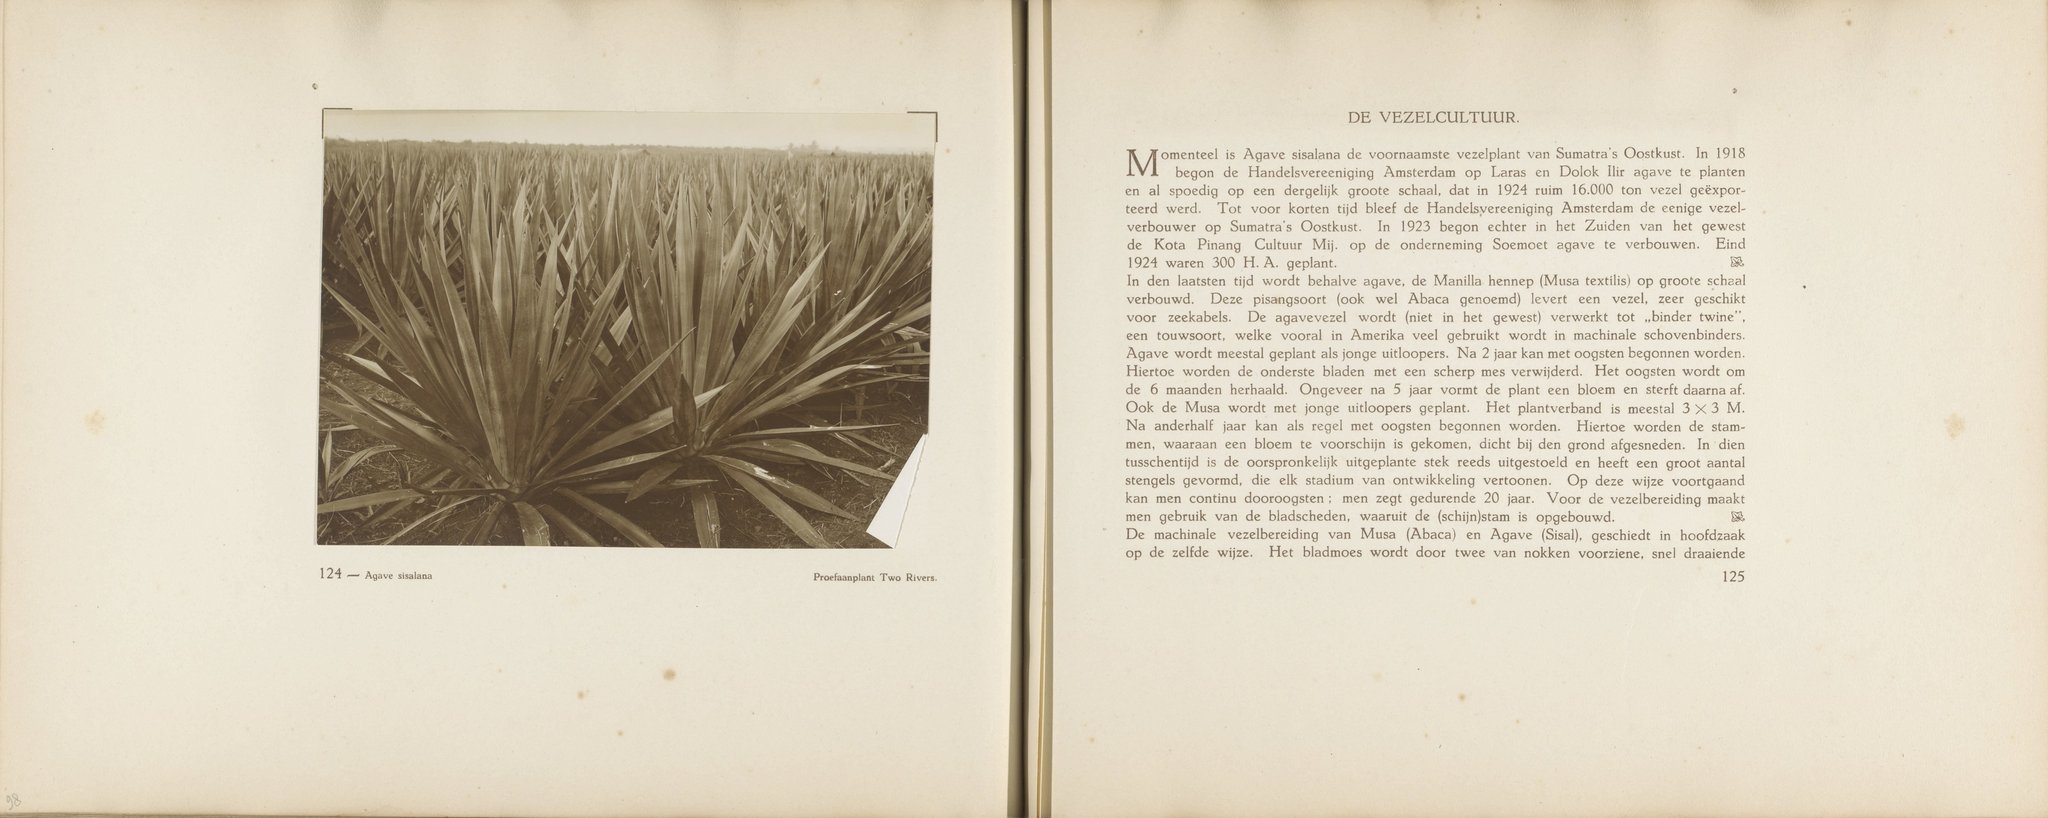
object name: album leaf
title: Pagina 124 en 125 van fotoboek van de Algemeene Vereeniging van Rubberplanters ter Oostkust van Sumatra (A.V.R.O.S.)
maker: j.w. meyster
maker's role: fotograaf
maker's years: 1887-1945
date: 1924-1925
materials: paper, photographic support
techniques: printing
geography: sumatra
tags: field filled with a crop, plants; vegetation, (non-fruit) products of plants or trees: rubber, sumatra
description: Twee boekpagina's met links een foto van agaveplanten (agave sisalana) op de proefaanplant Two Rivers op Sumatra en rechts informatie over de vezelcultuur. Onderdeel van een fotoboek van de Algemeene Vereeniging van Rubberplanters ter Oostkust van Sumatra (A.V.R.O.S.).